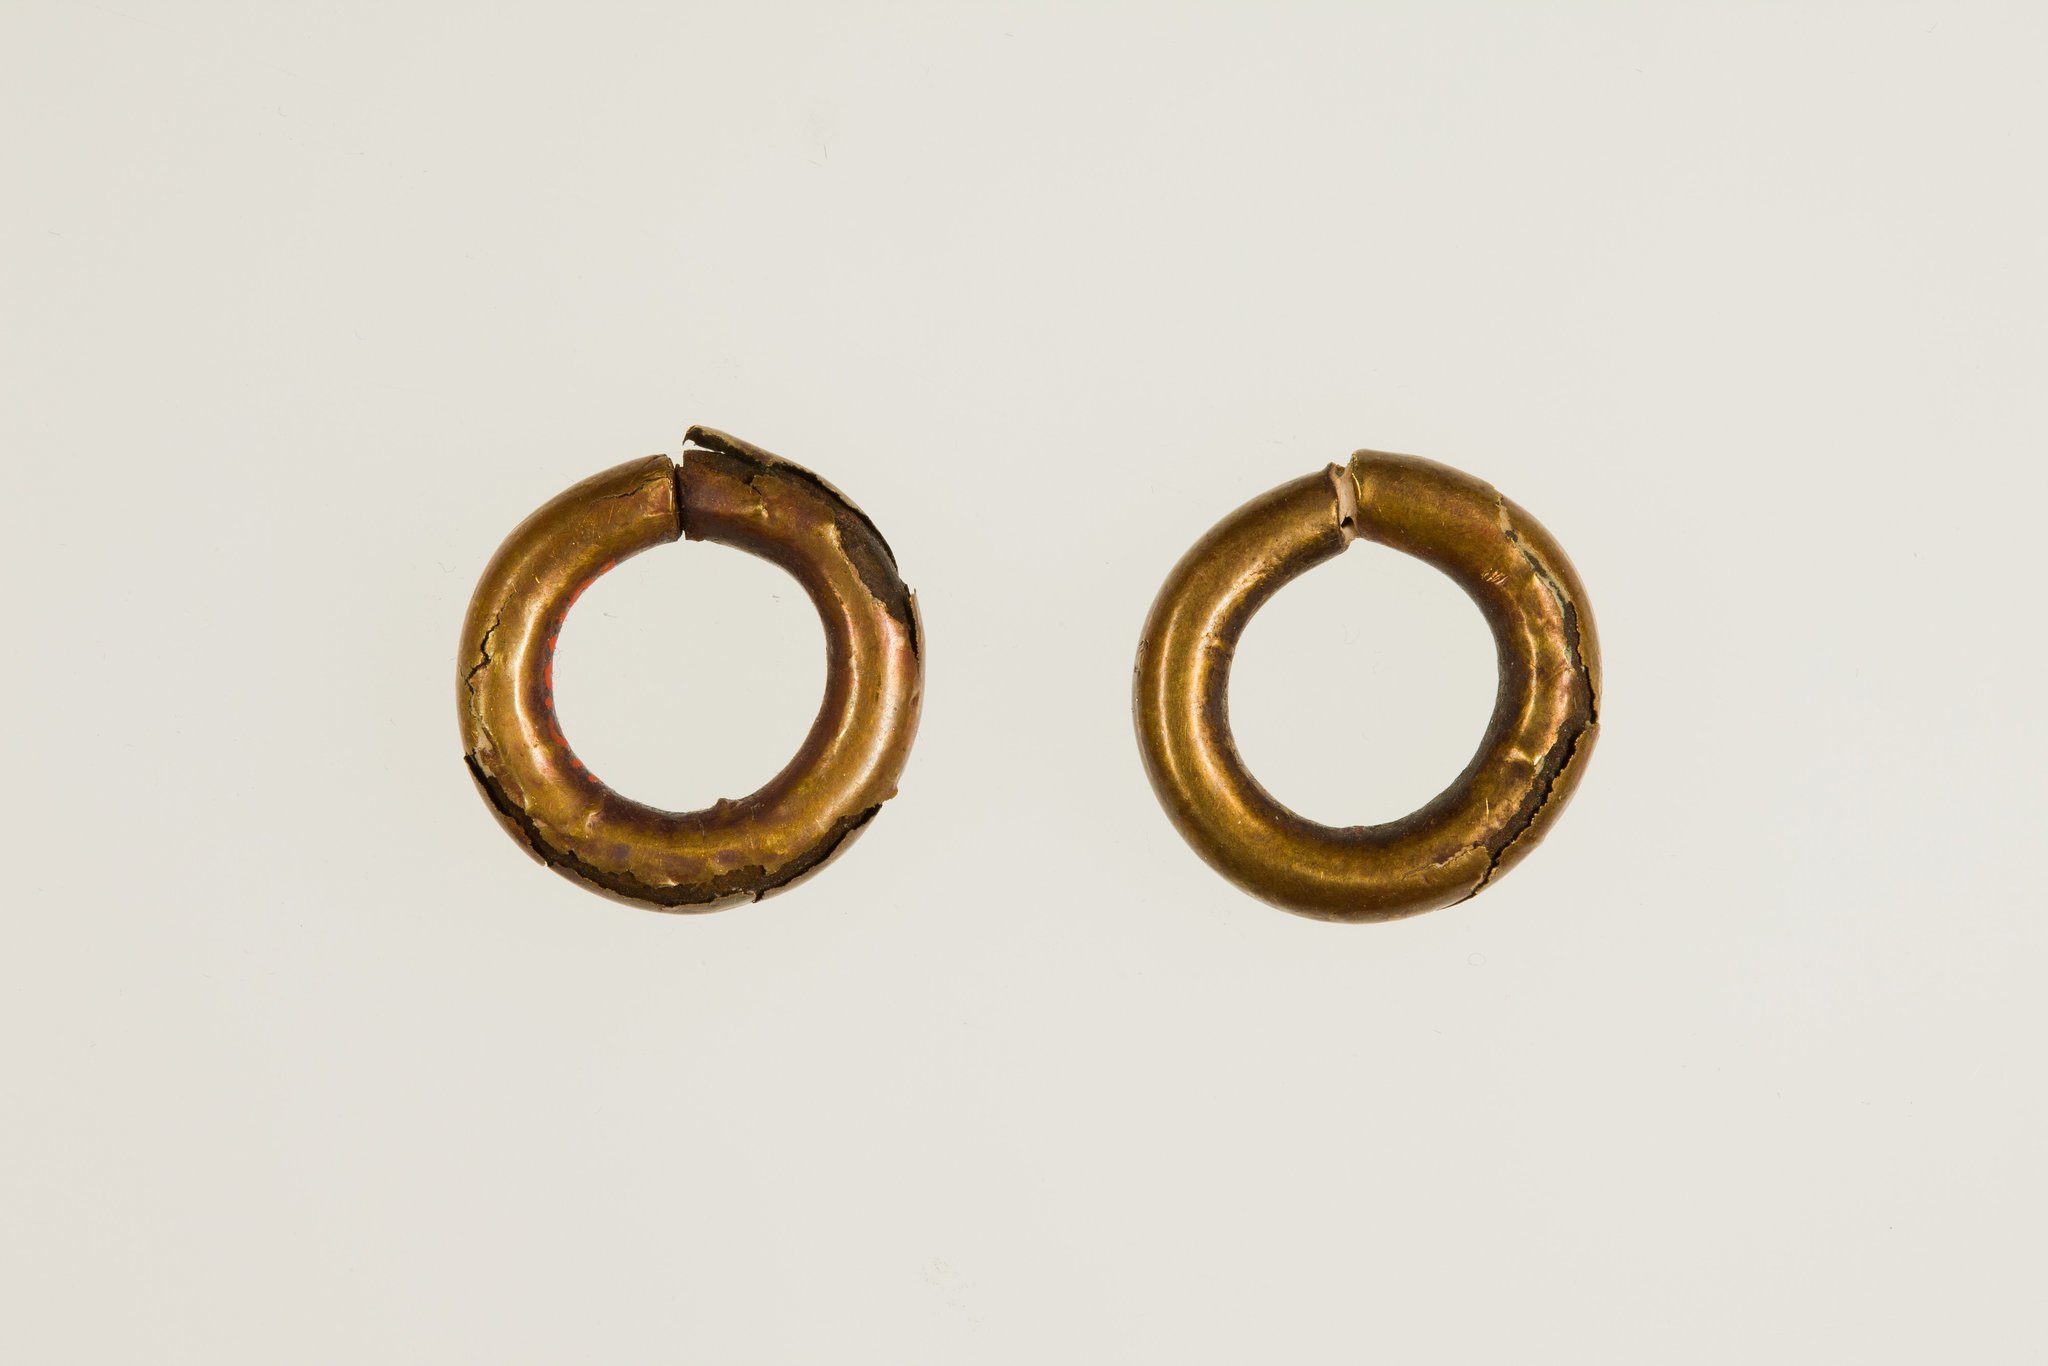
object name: earring, pennanular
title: Pair of Earrings (with 16.10.311)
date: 1635-1458 BCE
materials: bronze, copper alloy, gold foil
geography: egypt